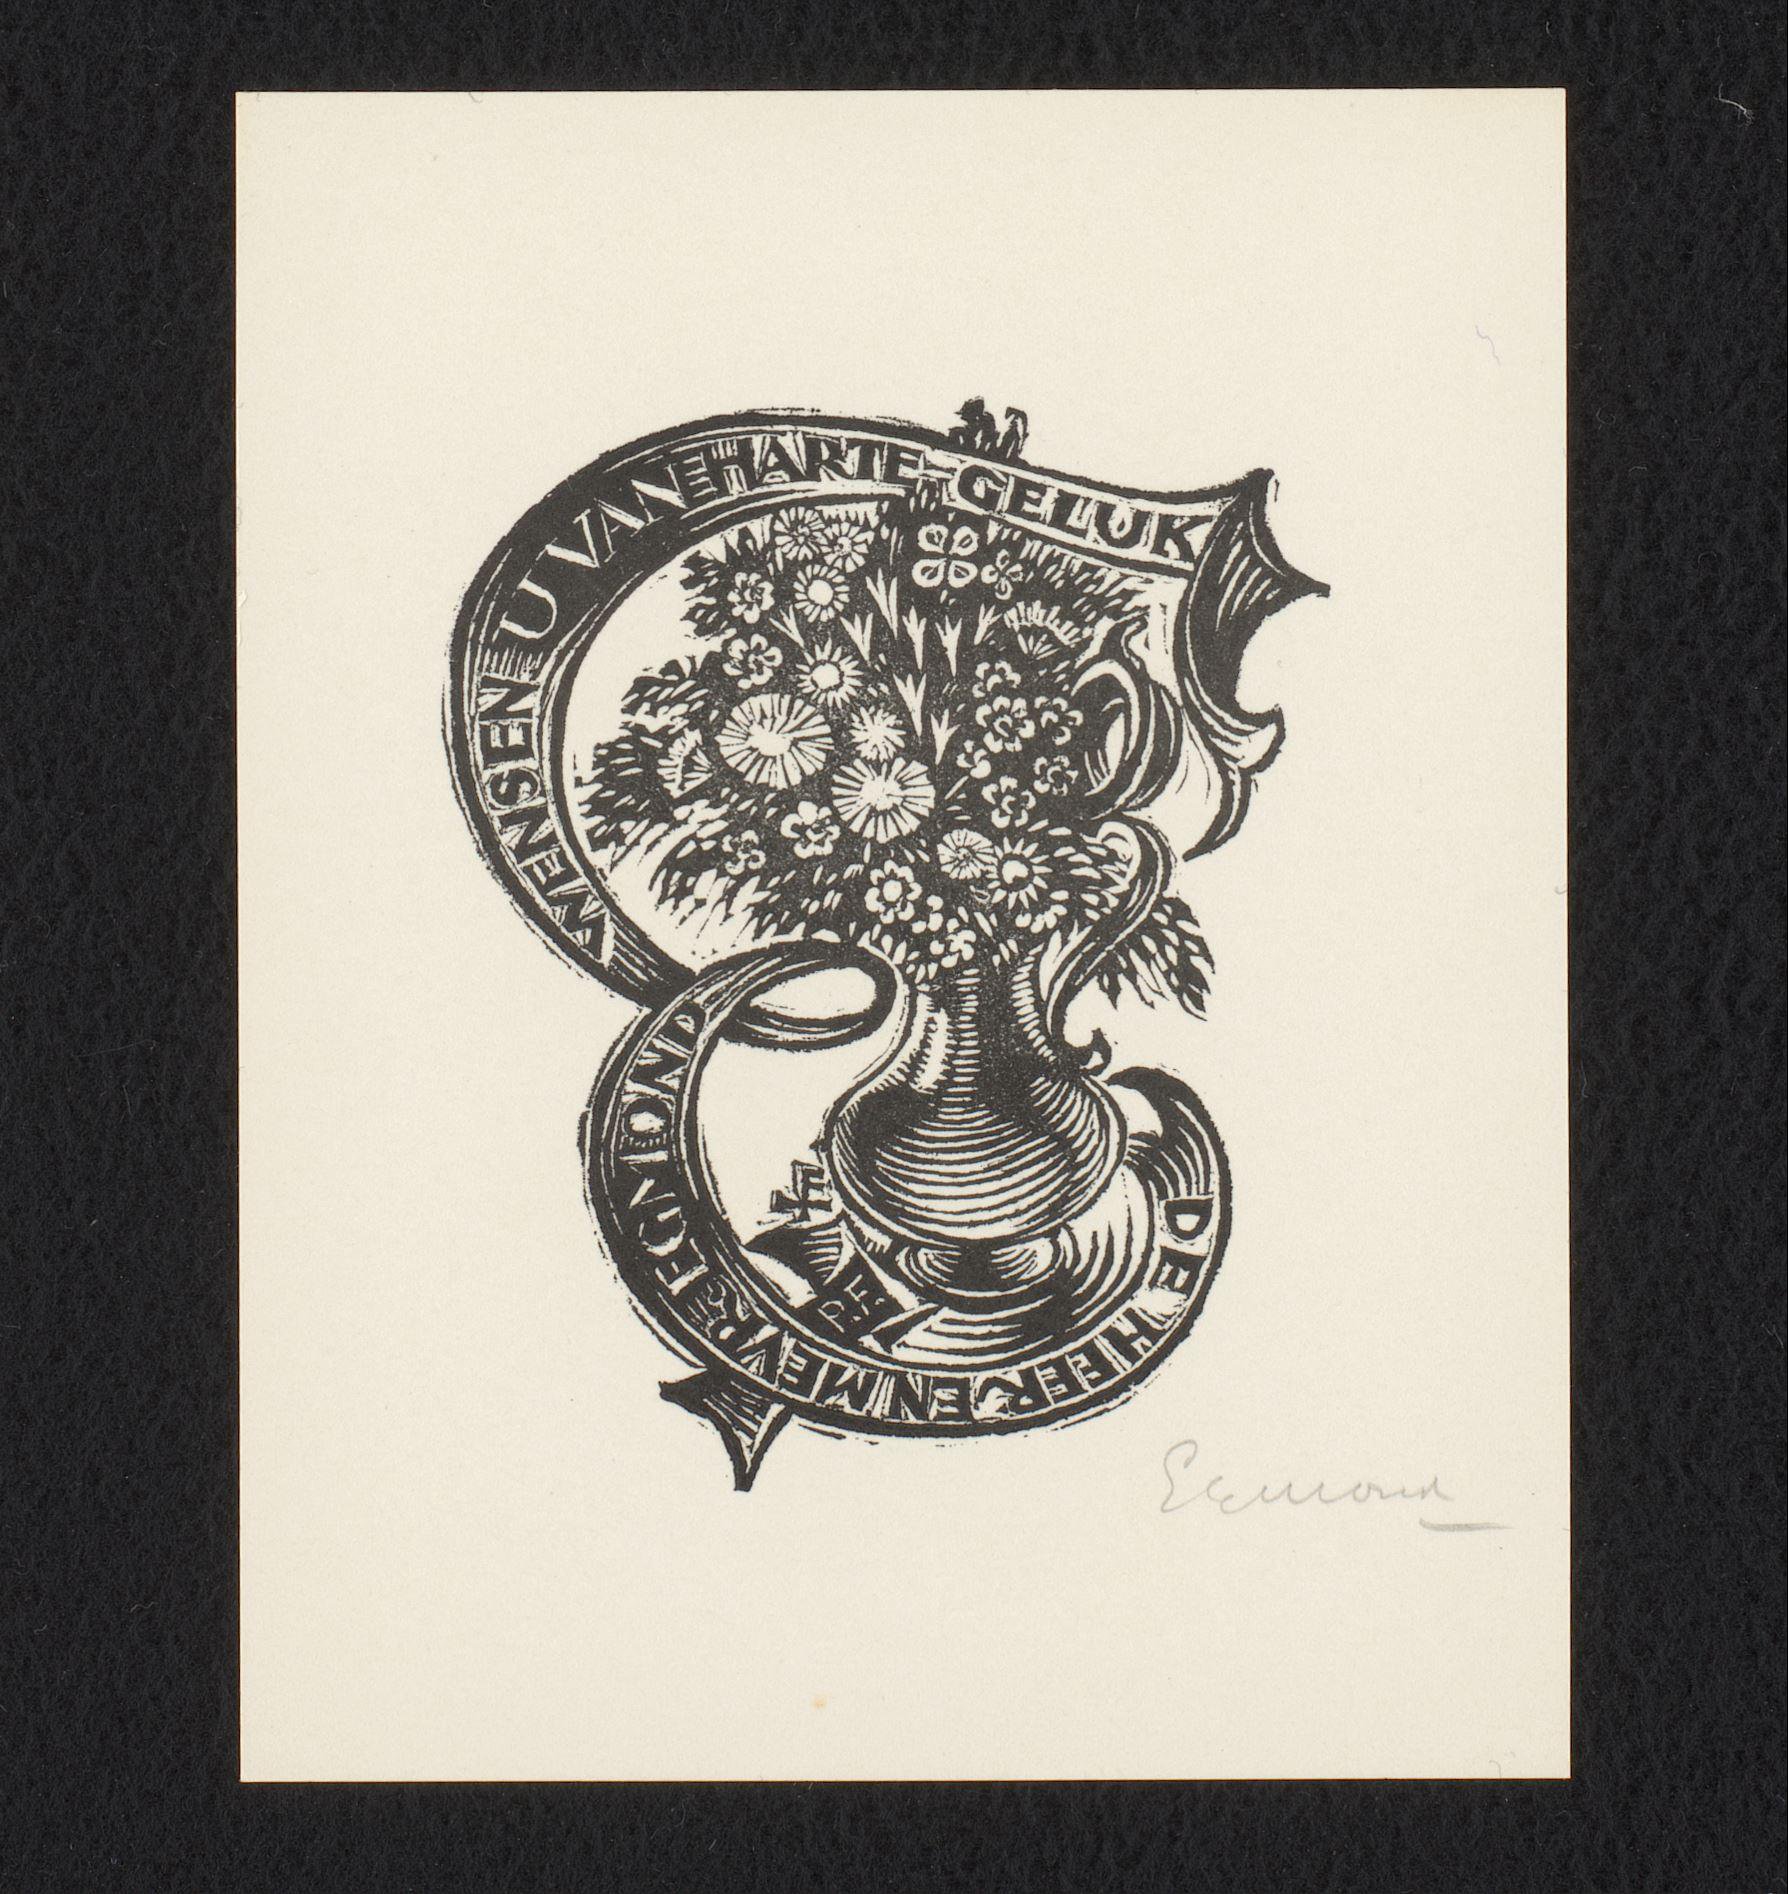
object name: print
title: Wenskaart van de heer en mevrouw Egmond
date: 1925-1975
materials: paper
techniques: linocut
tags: flowers in a vase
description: Vervaardiging van dit object is onduidelijk. Hoewel Jaap Egmond als kunstenaar actief was, maakte deze voor zover bekend geen linoleumsneden. Een aantal houtsneden die bekend zijn, zijn heel anders gesigneerd. Verder is het monogram P.F. moeilijk te duiden als Egmond zelf deze prent gemaakt zou hebben.